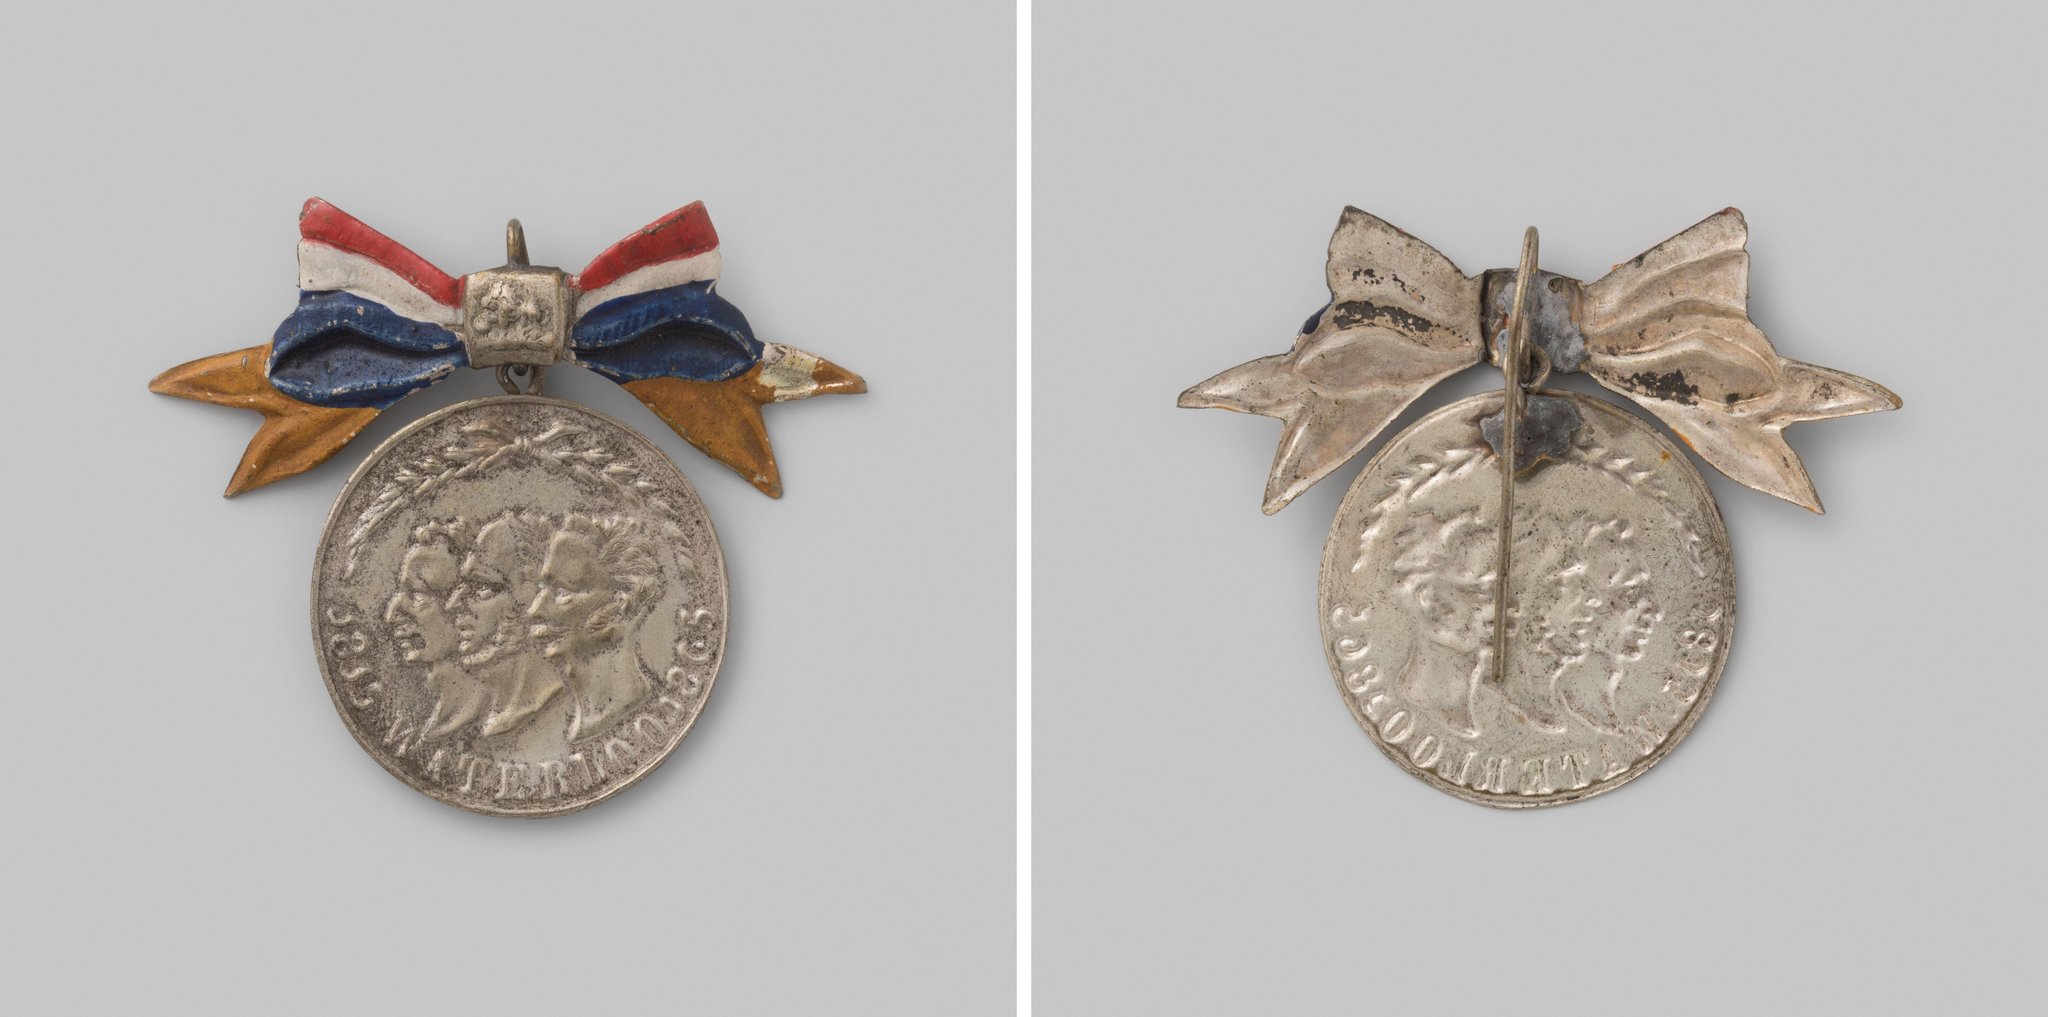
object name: insignia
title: Vijftigjarige herdenking van de slag bij Waterloo, ter ere van Wellington, Willem II en Blucher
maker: Anonymous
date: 1865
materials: tin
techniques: striking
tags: william ii of the netherlands, walmer castle, arthur wellesley of wellington, waterloo